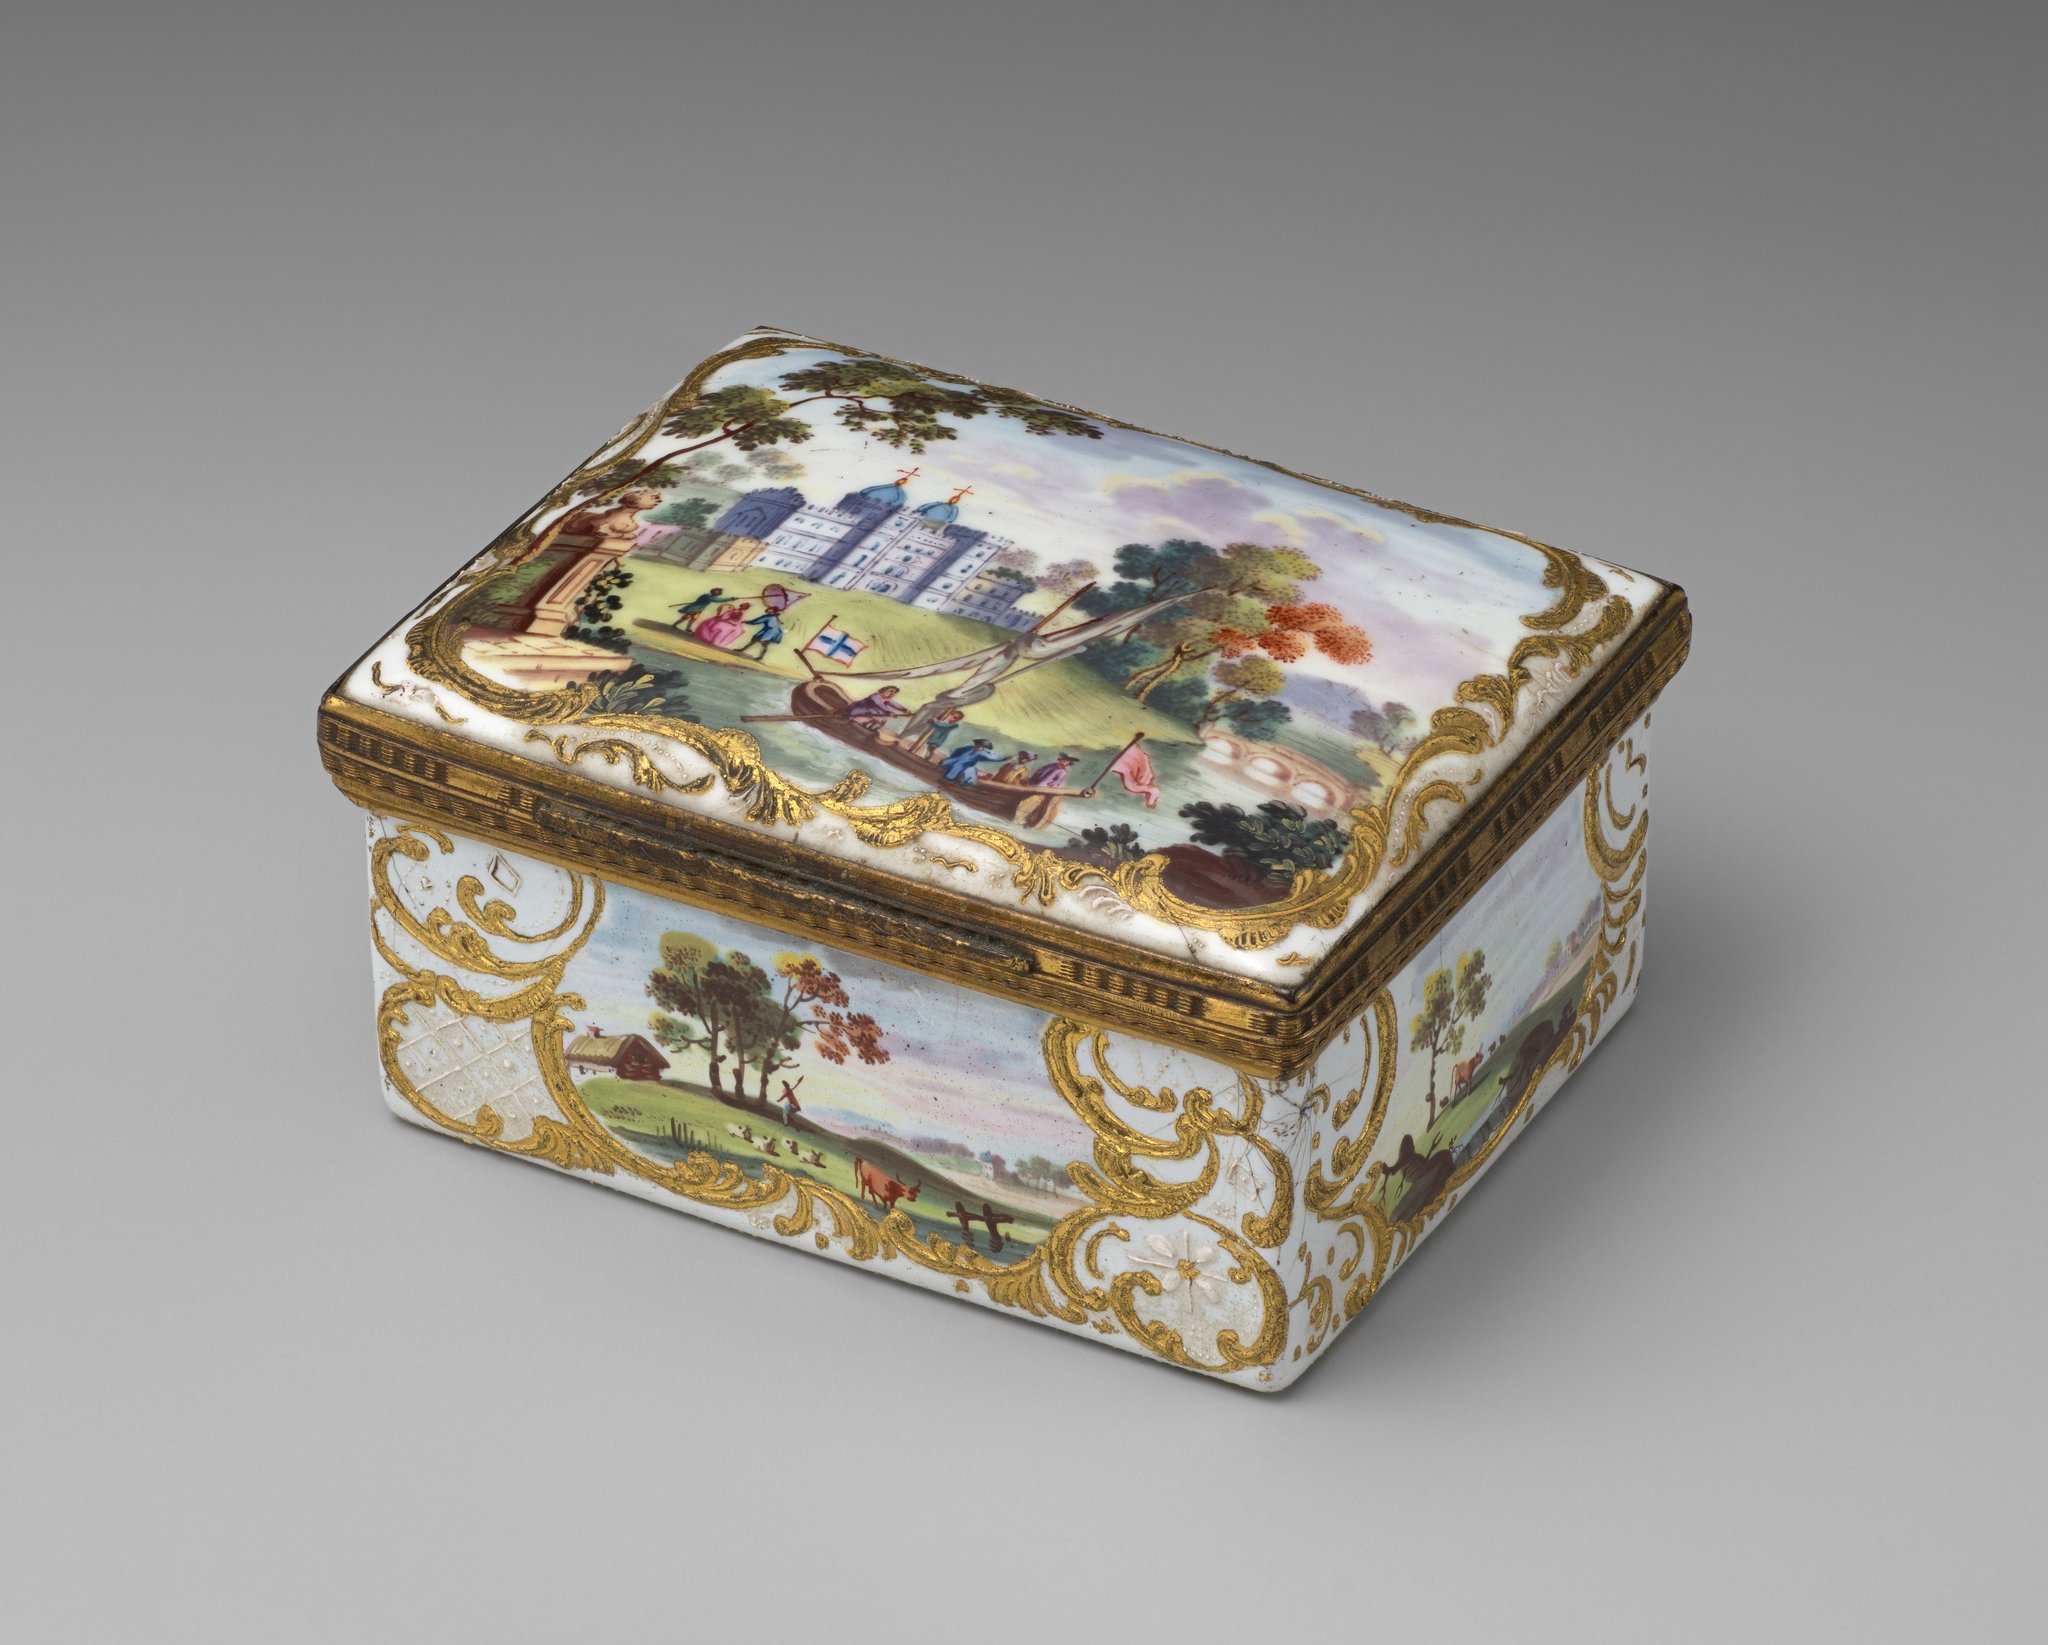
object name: snuffbox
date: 1765-1770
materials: copper, enamel